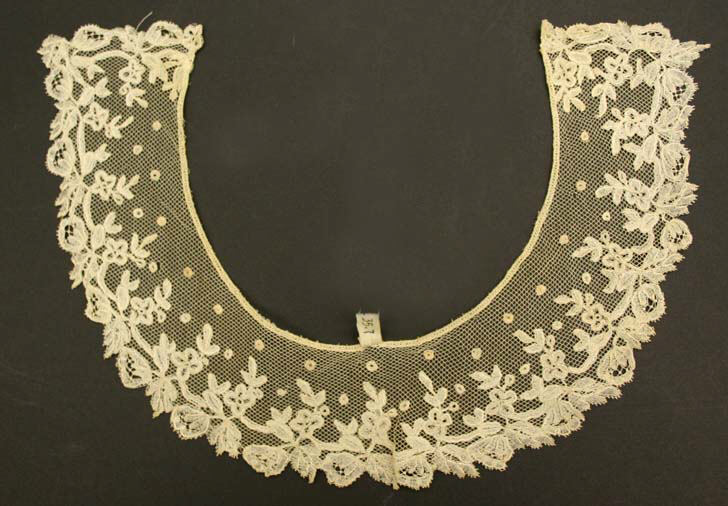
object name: collar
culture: american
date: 1700-1941